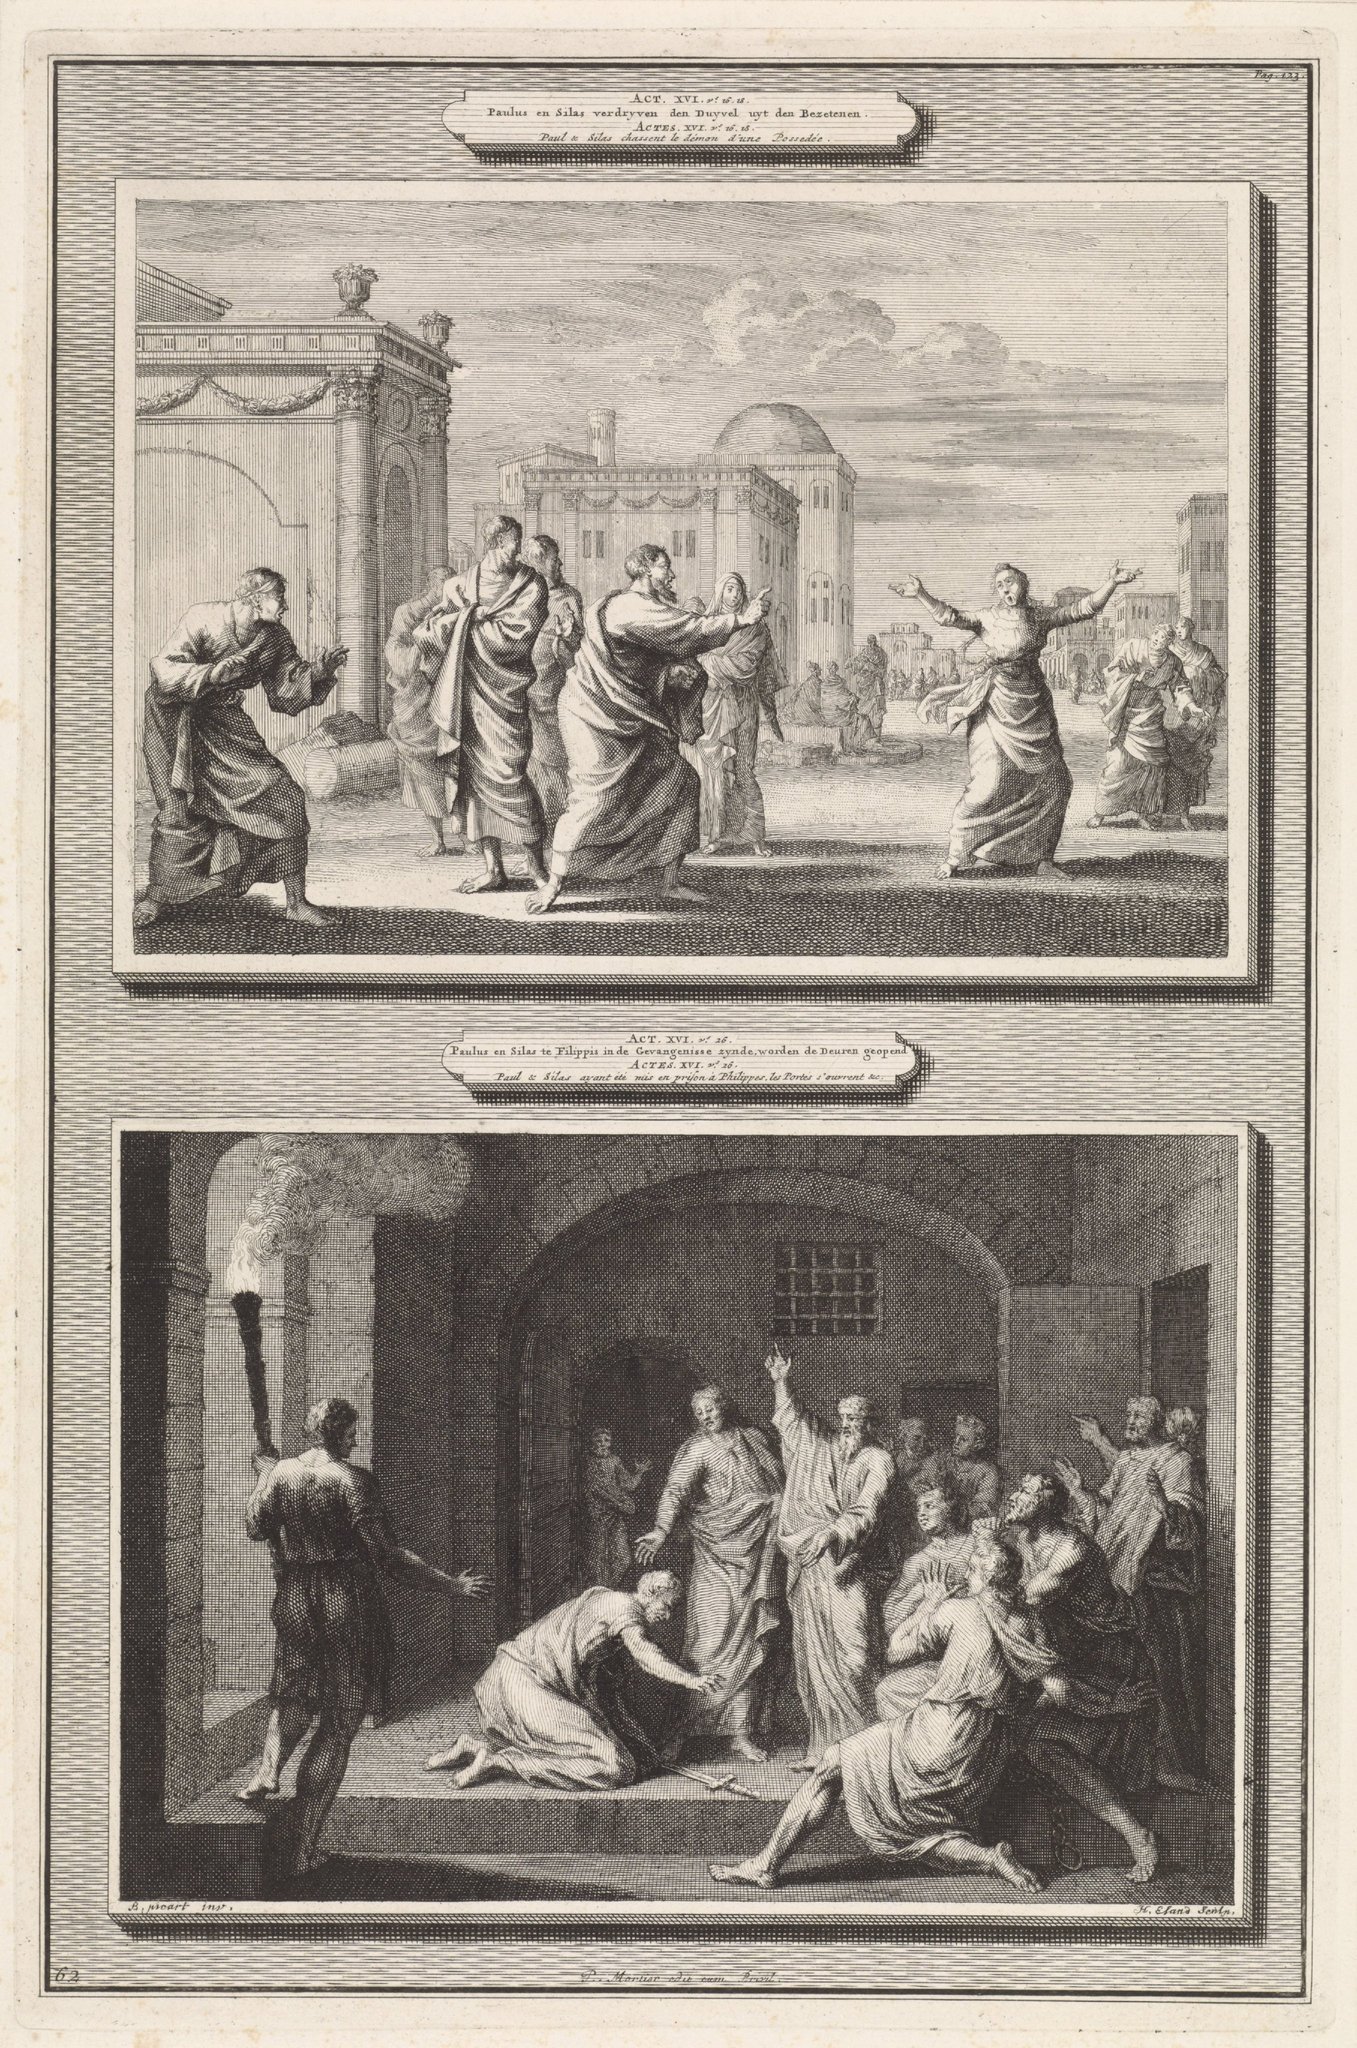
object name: print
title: Paulus geneest een bezeten vrouw en de bekering van de gevangenenbewaarder van Filippi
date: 1700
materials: paper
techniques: etching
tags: the prison-doors are opened by an earthquake ~ paul and silas in prison, paul and silas teach the word of god to the warder, who kneels before them, the healing of the woman servant with a divining spirit ~ paul and silas at philippi, paul and silas prevent the warder from committing suicide (story of the conversion of the warder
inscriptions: collector's mark: Lugt 2228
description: Twee voorstellingen op een plaat. Boven: een bezeten vrouw die Paulus en Silas achtervolgt, wordt door Paulus aangesproken. In naam van Christus beveelt hij de geest die in haar huist het lichaam van de vrouw te verlaten. Onder: Paulus en Silas en hun medegevangenen zijn door een aardbeving bevrijd uit de gevangenis. De gevangenbewaarder, die ziet dat alle deuren zijn opengesprongen, wil zelfmoord plegen met zijn zwaard, maar Paulus en Silas weerhouden hem daarvan. Paulus bekeert de gevangenenbewaarder vervolgens.